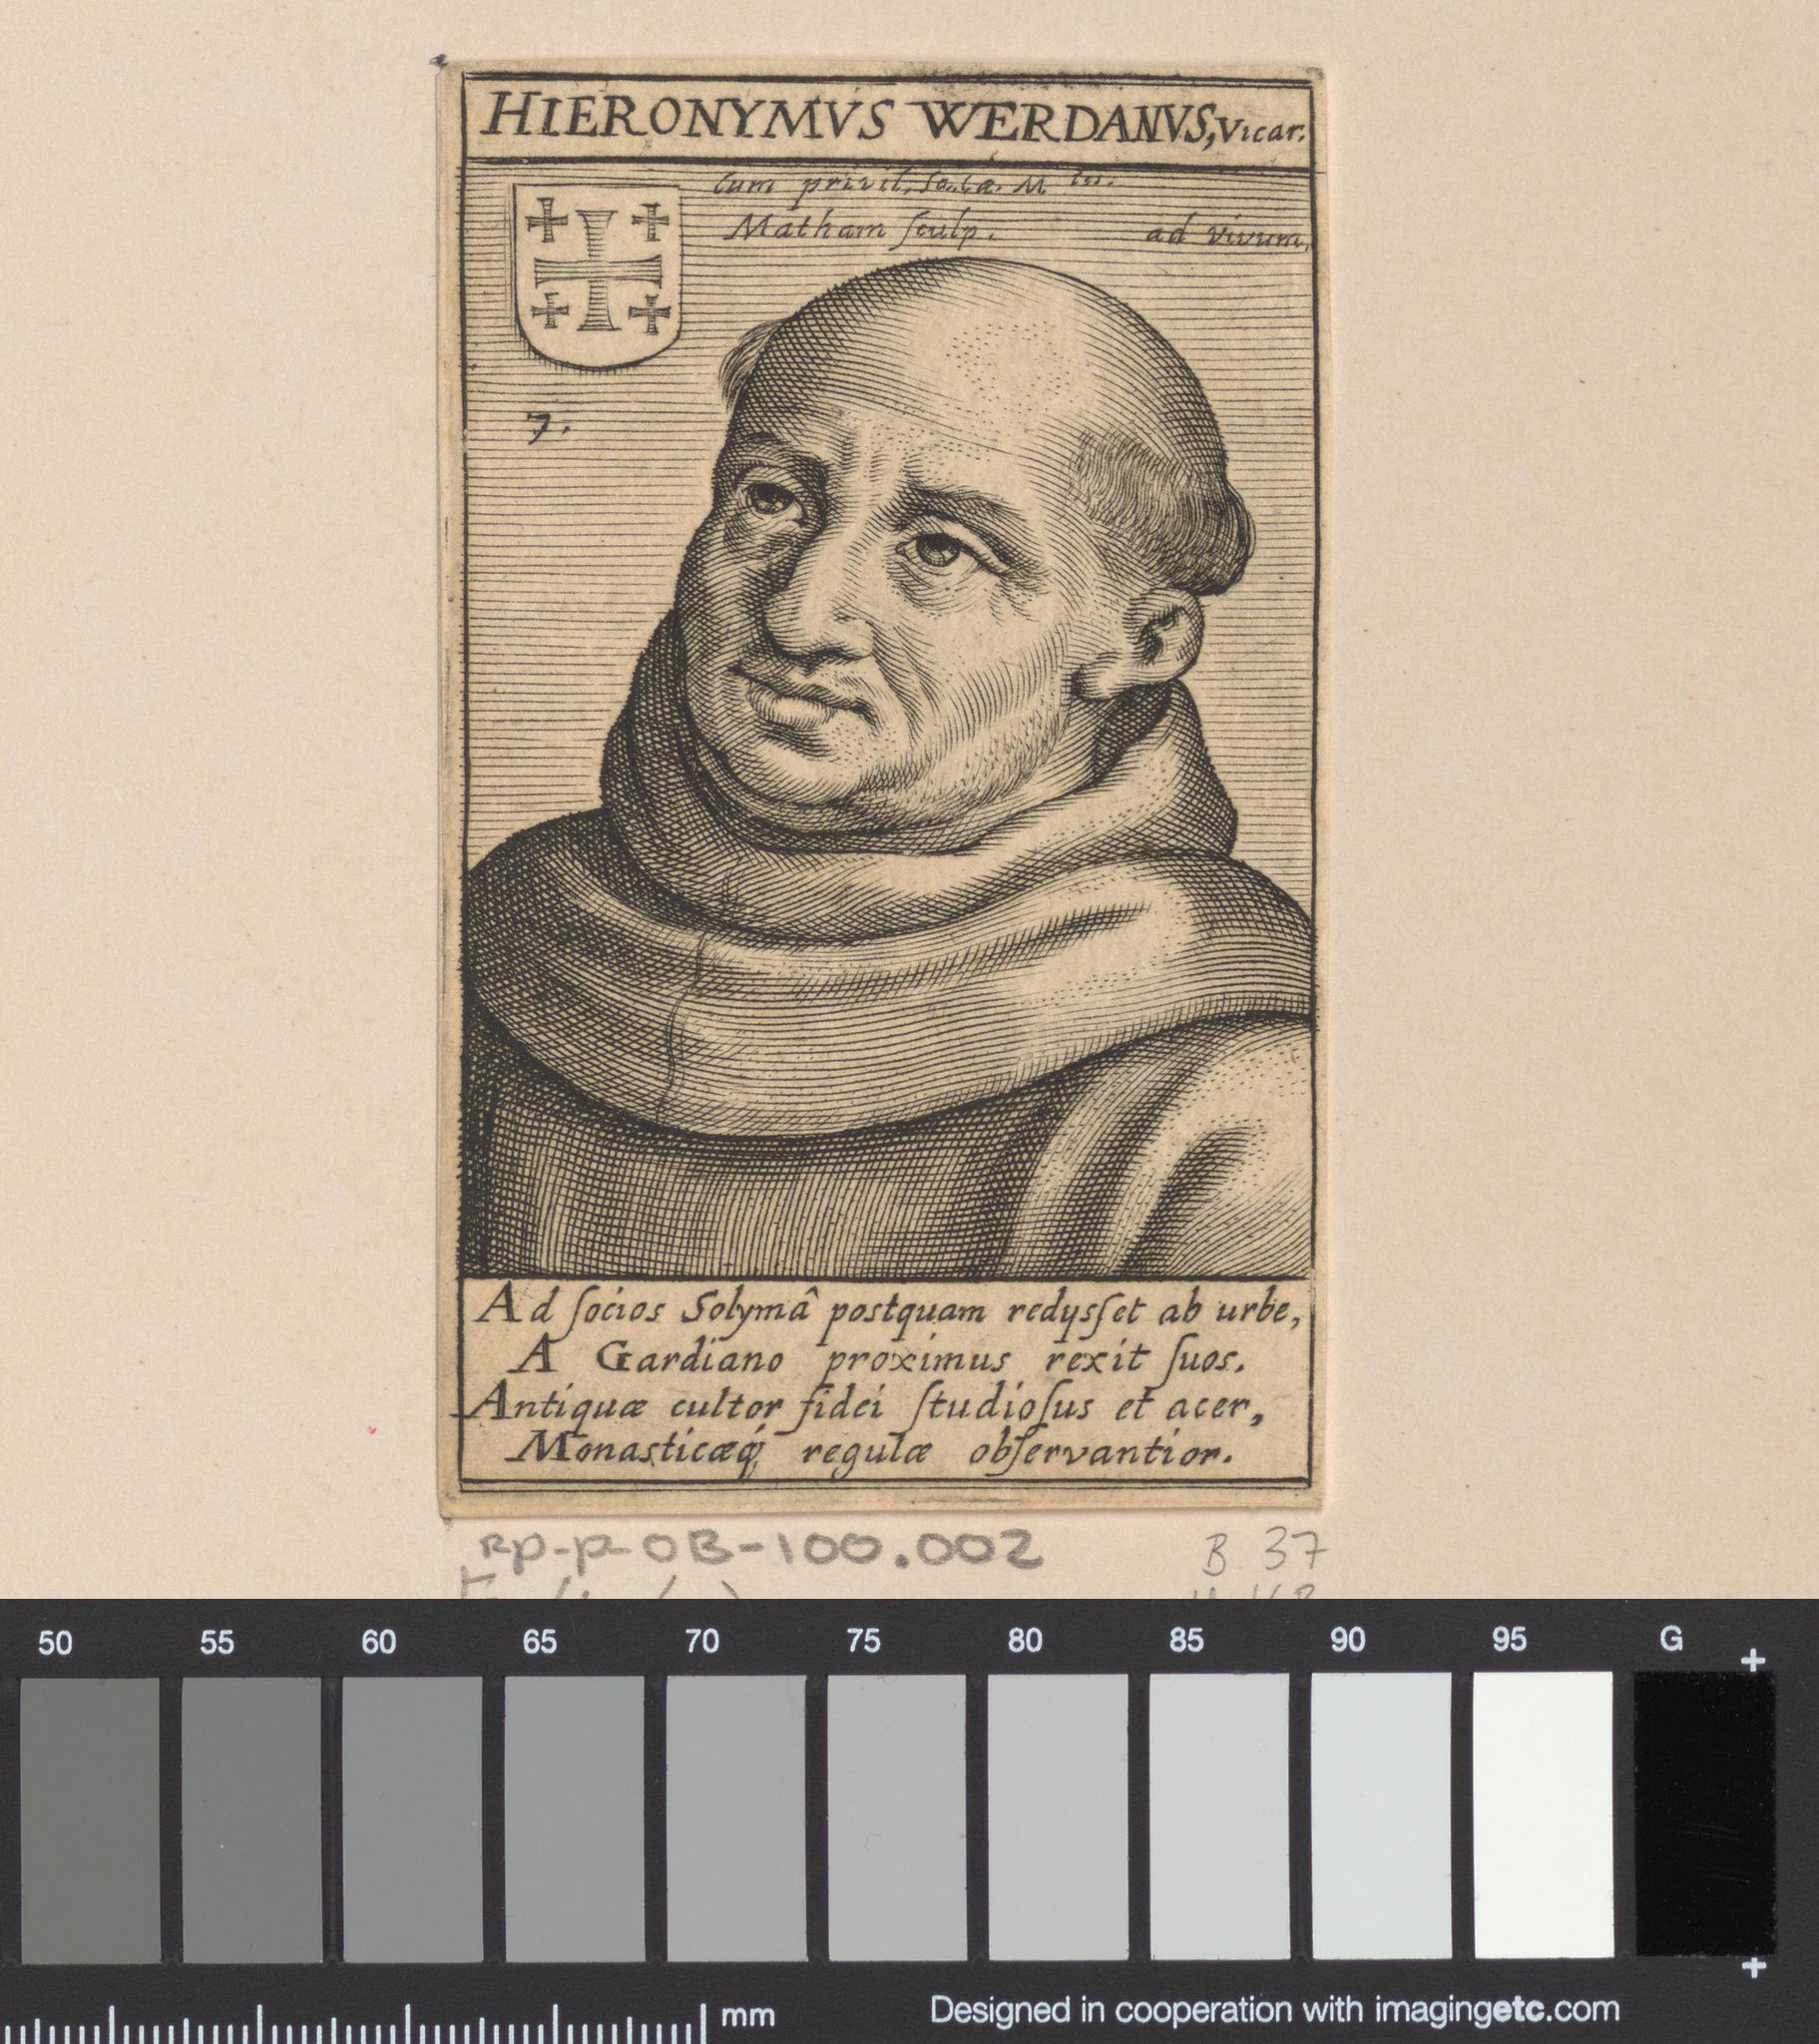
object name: print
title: De martelaren van Gorcum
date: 1617-1618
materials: paper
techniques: engraving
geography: haarlem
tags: martyrs of gorkum, historical persons, armorial bearing, heraldry, brielle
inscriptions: collector's mark: Lugt 964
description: Genummerd linksboven: 7. Met een vierregelig onderschrift in het Latijn.